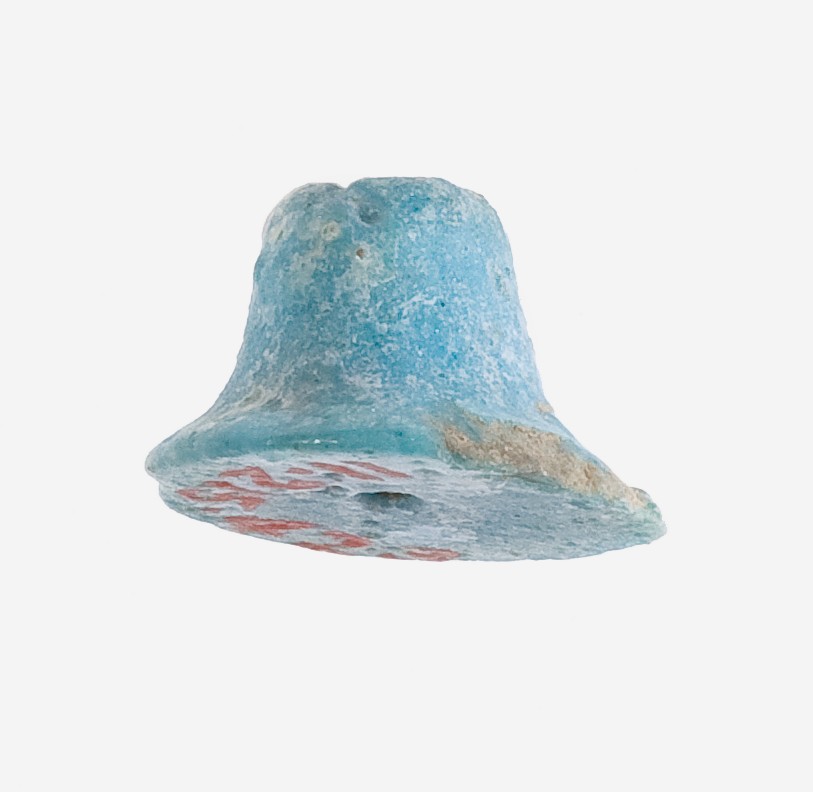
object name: pendant, umbel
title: Umbel Pendant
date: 1390-1352 BCE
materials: faience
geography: egypt